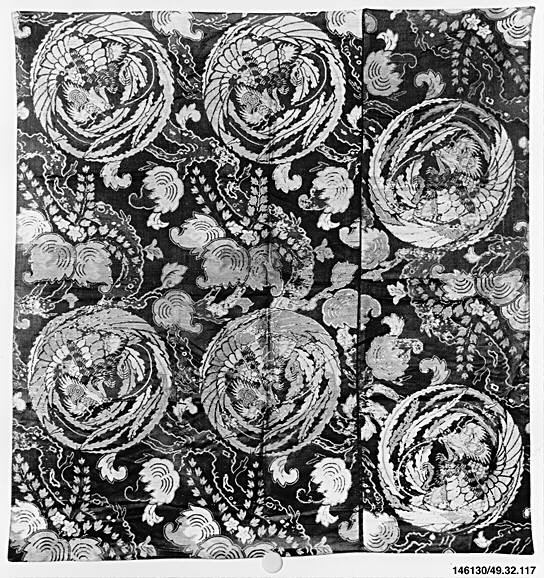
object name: altar cloth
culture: japanese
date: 1701-1900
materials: metal thread, silk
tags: flowers